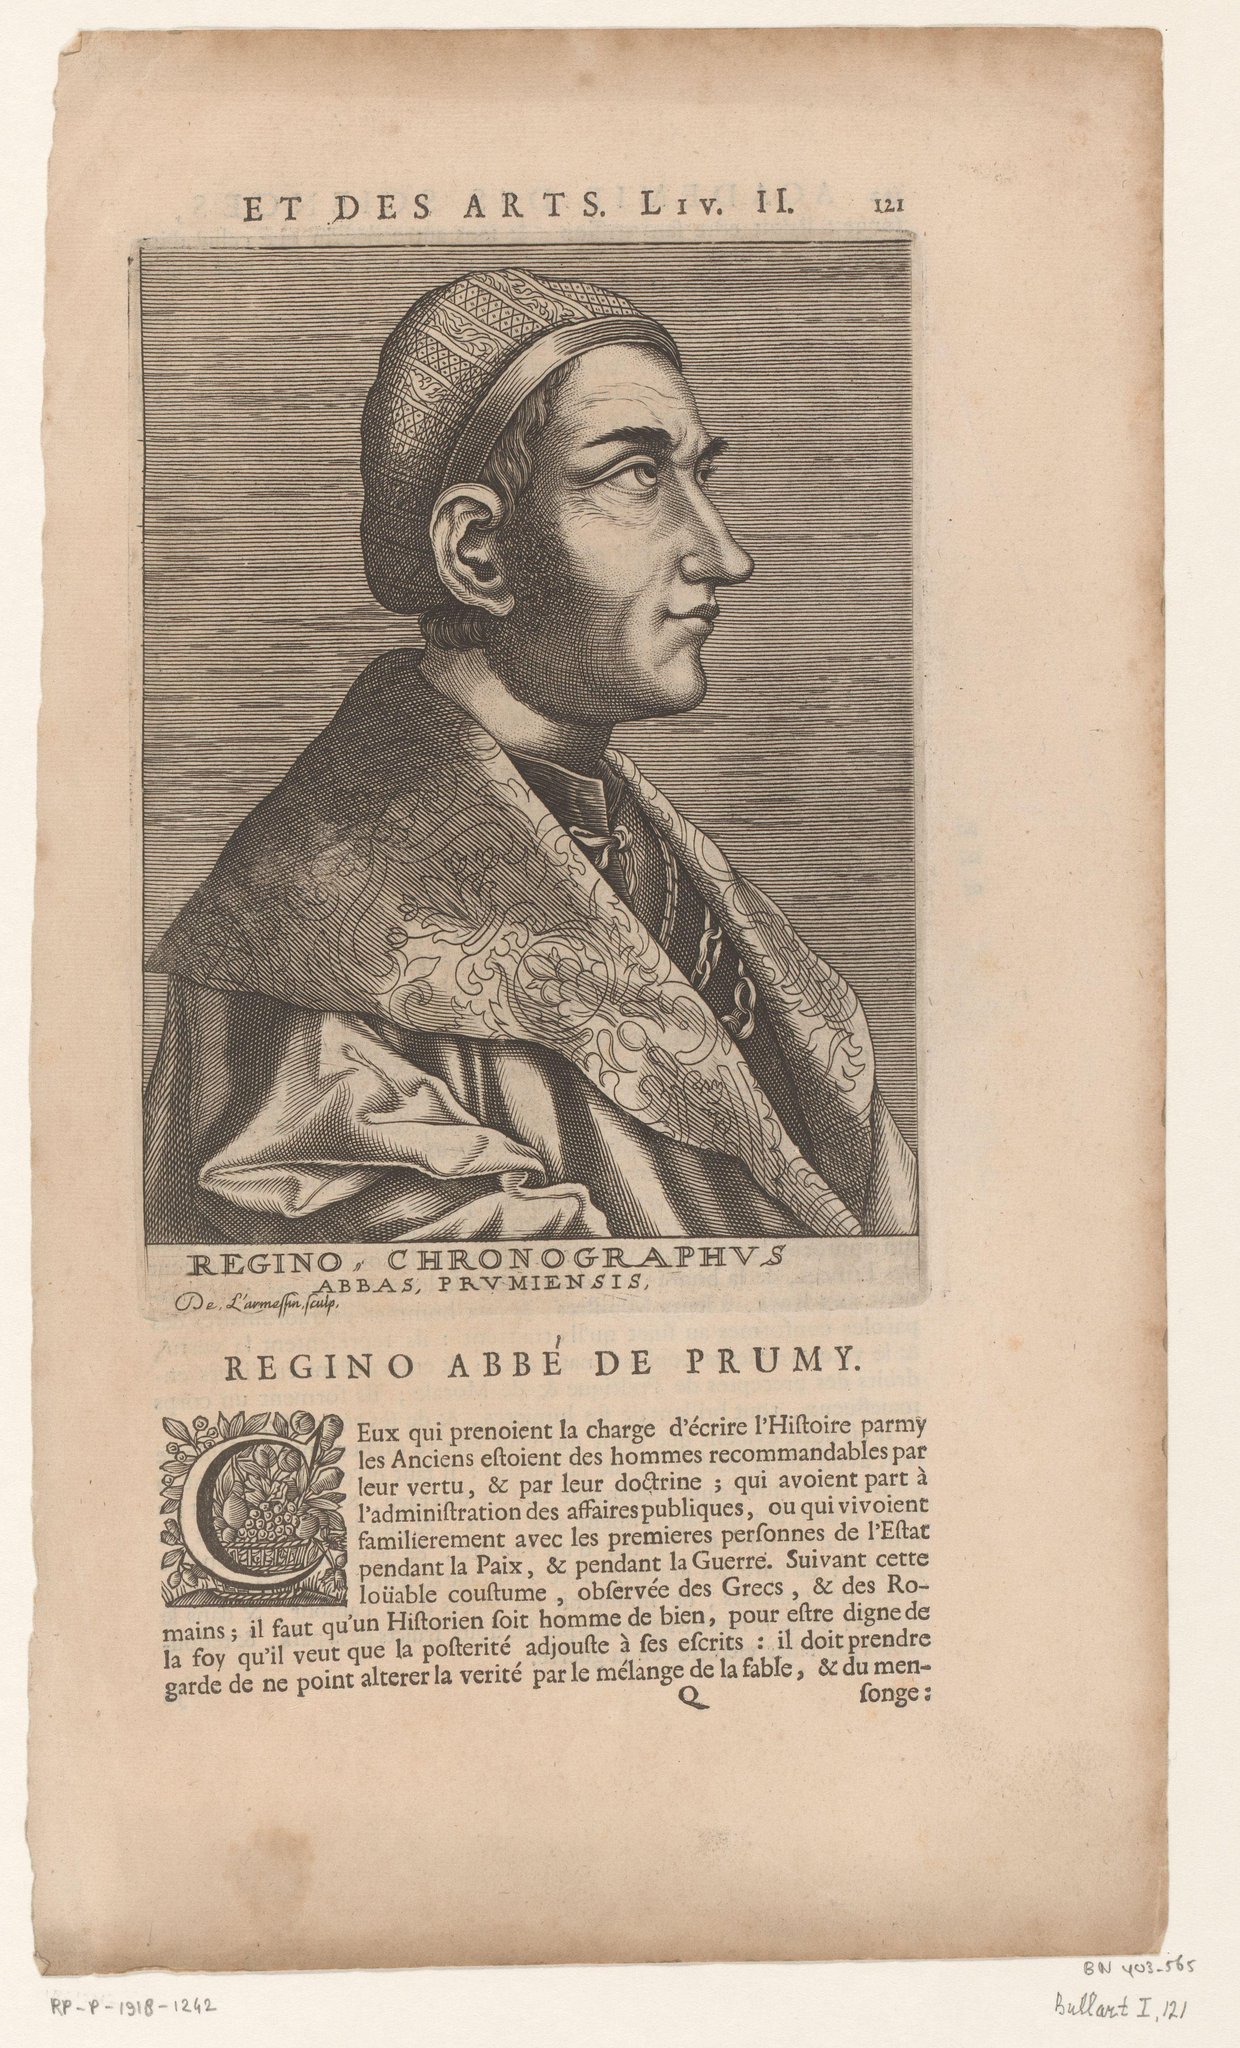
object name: print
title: Portret van Regino von Prüm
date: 1682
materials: paper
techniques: engraving, letterpress printing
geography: brussels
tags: abbot, historical persons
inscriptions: collector's mark: Lugt 2233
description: Prent gebruikt voor: Bullart, Isaac. Académie des Sciences et Arts contenant les vies et éloges his. des hommes illustres qui ont excellé en ces professions depuis environ quatre siècles. Brussel: François Foppens, 1682. Het boek werd in 1682 eveneens in Amsterdam uitgegeven door de erfgenamen van Daniel Elzevier. Ieder portret betreft een illustratie bij de biografie van een kunstenaar of geleerde. De meeste portretten werden door Nicolas de Larmessin vervaardigd (162), 93 door De Boulonois en een derde door ongeïdentificeerde prentmakers. Dit betreft een illustratie op p. 121, deel I.